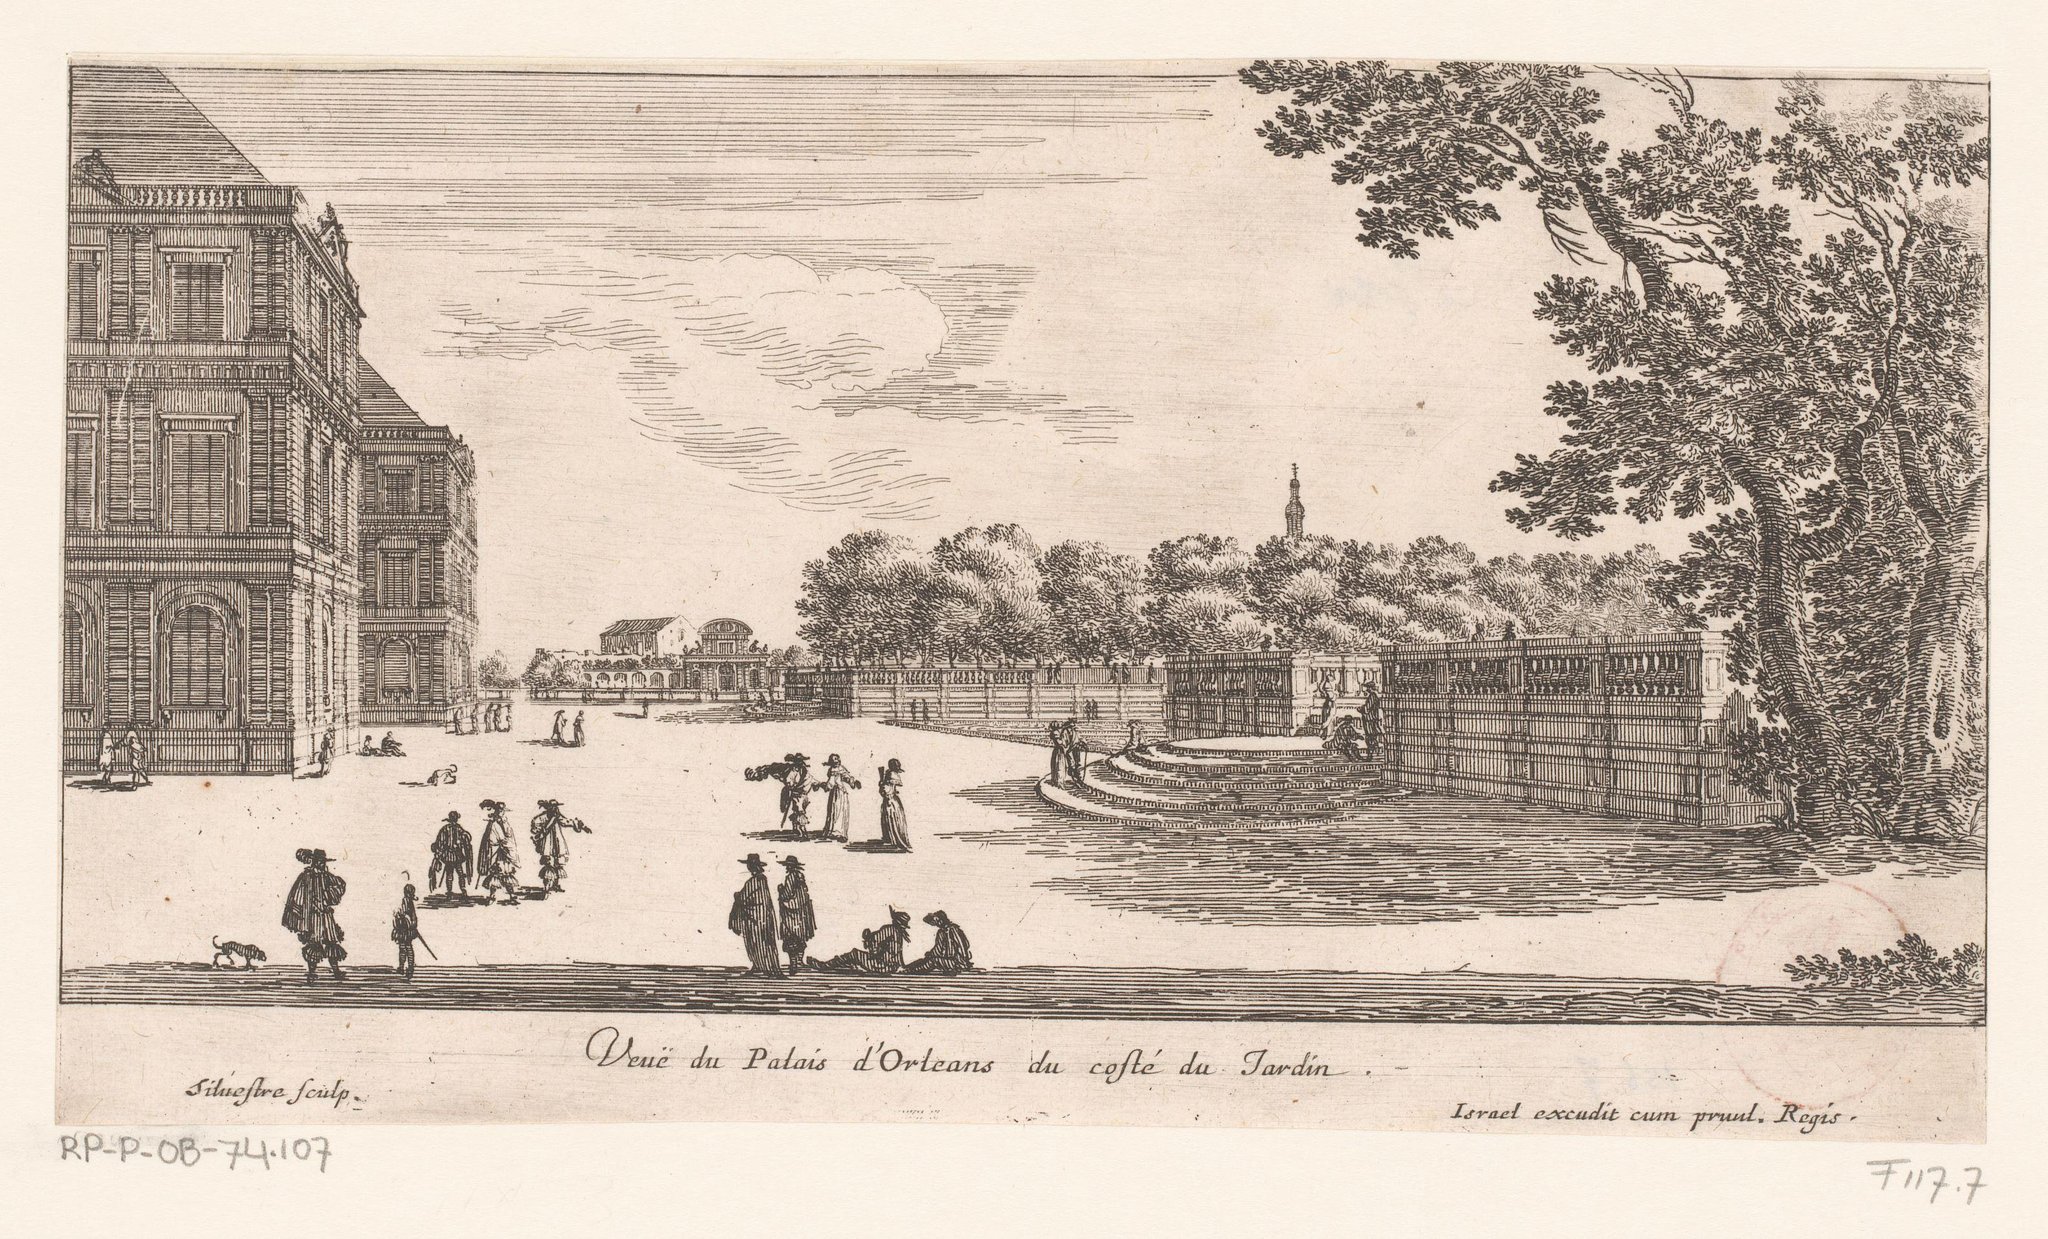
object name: print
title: Veue du Palais d'Orleans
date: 1631-1661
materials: paper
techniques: etching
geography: france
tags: palace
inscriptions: collector's mark: Lugt 240